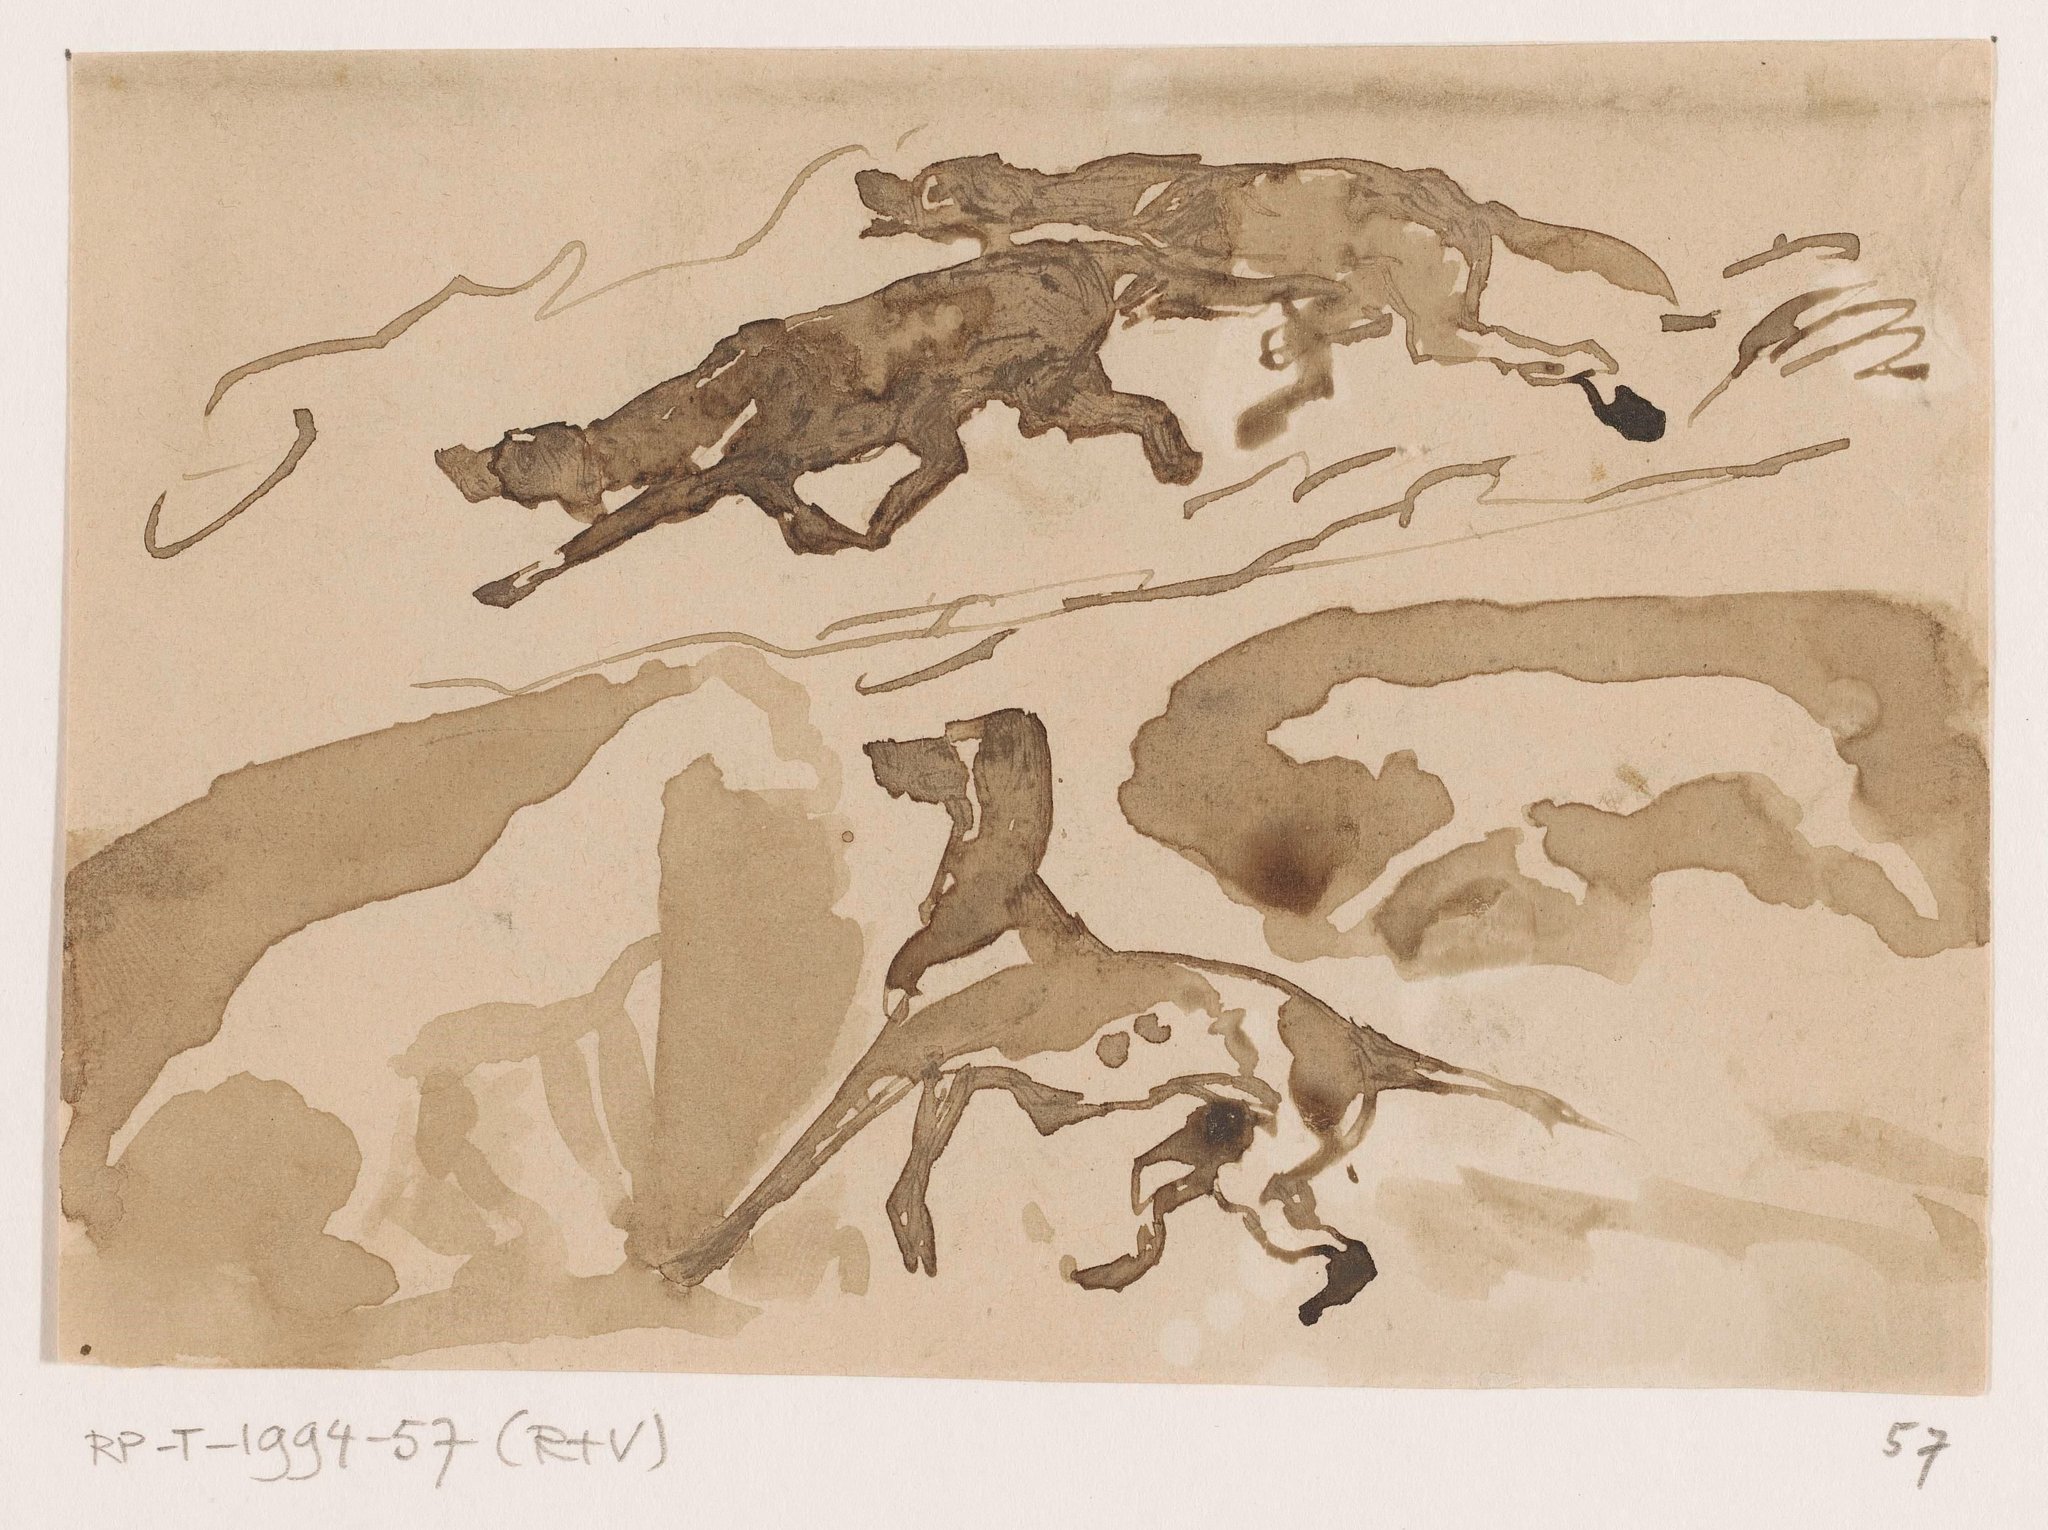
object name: drawing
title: Rennende jachthonden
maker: johannes tavenraat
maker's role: draughtsman, painter, print maker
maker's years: 1809-1881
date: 1819-1881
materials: paper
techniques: brush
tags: hunting dogs